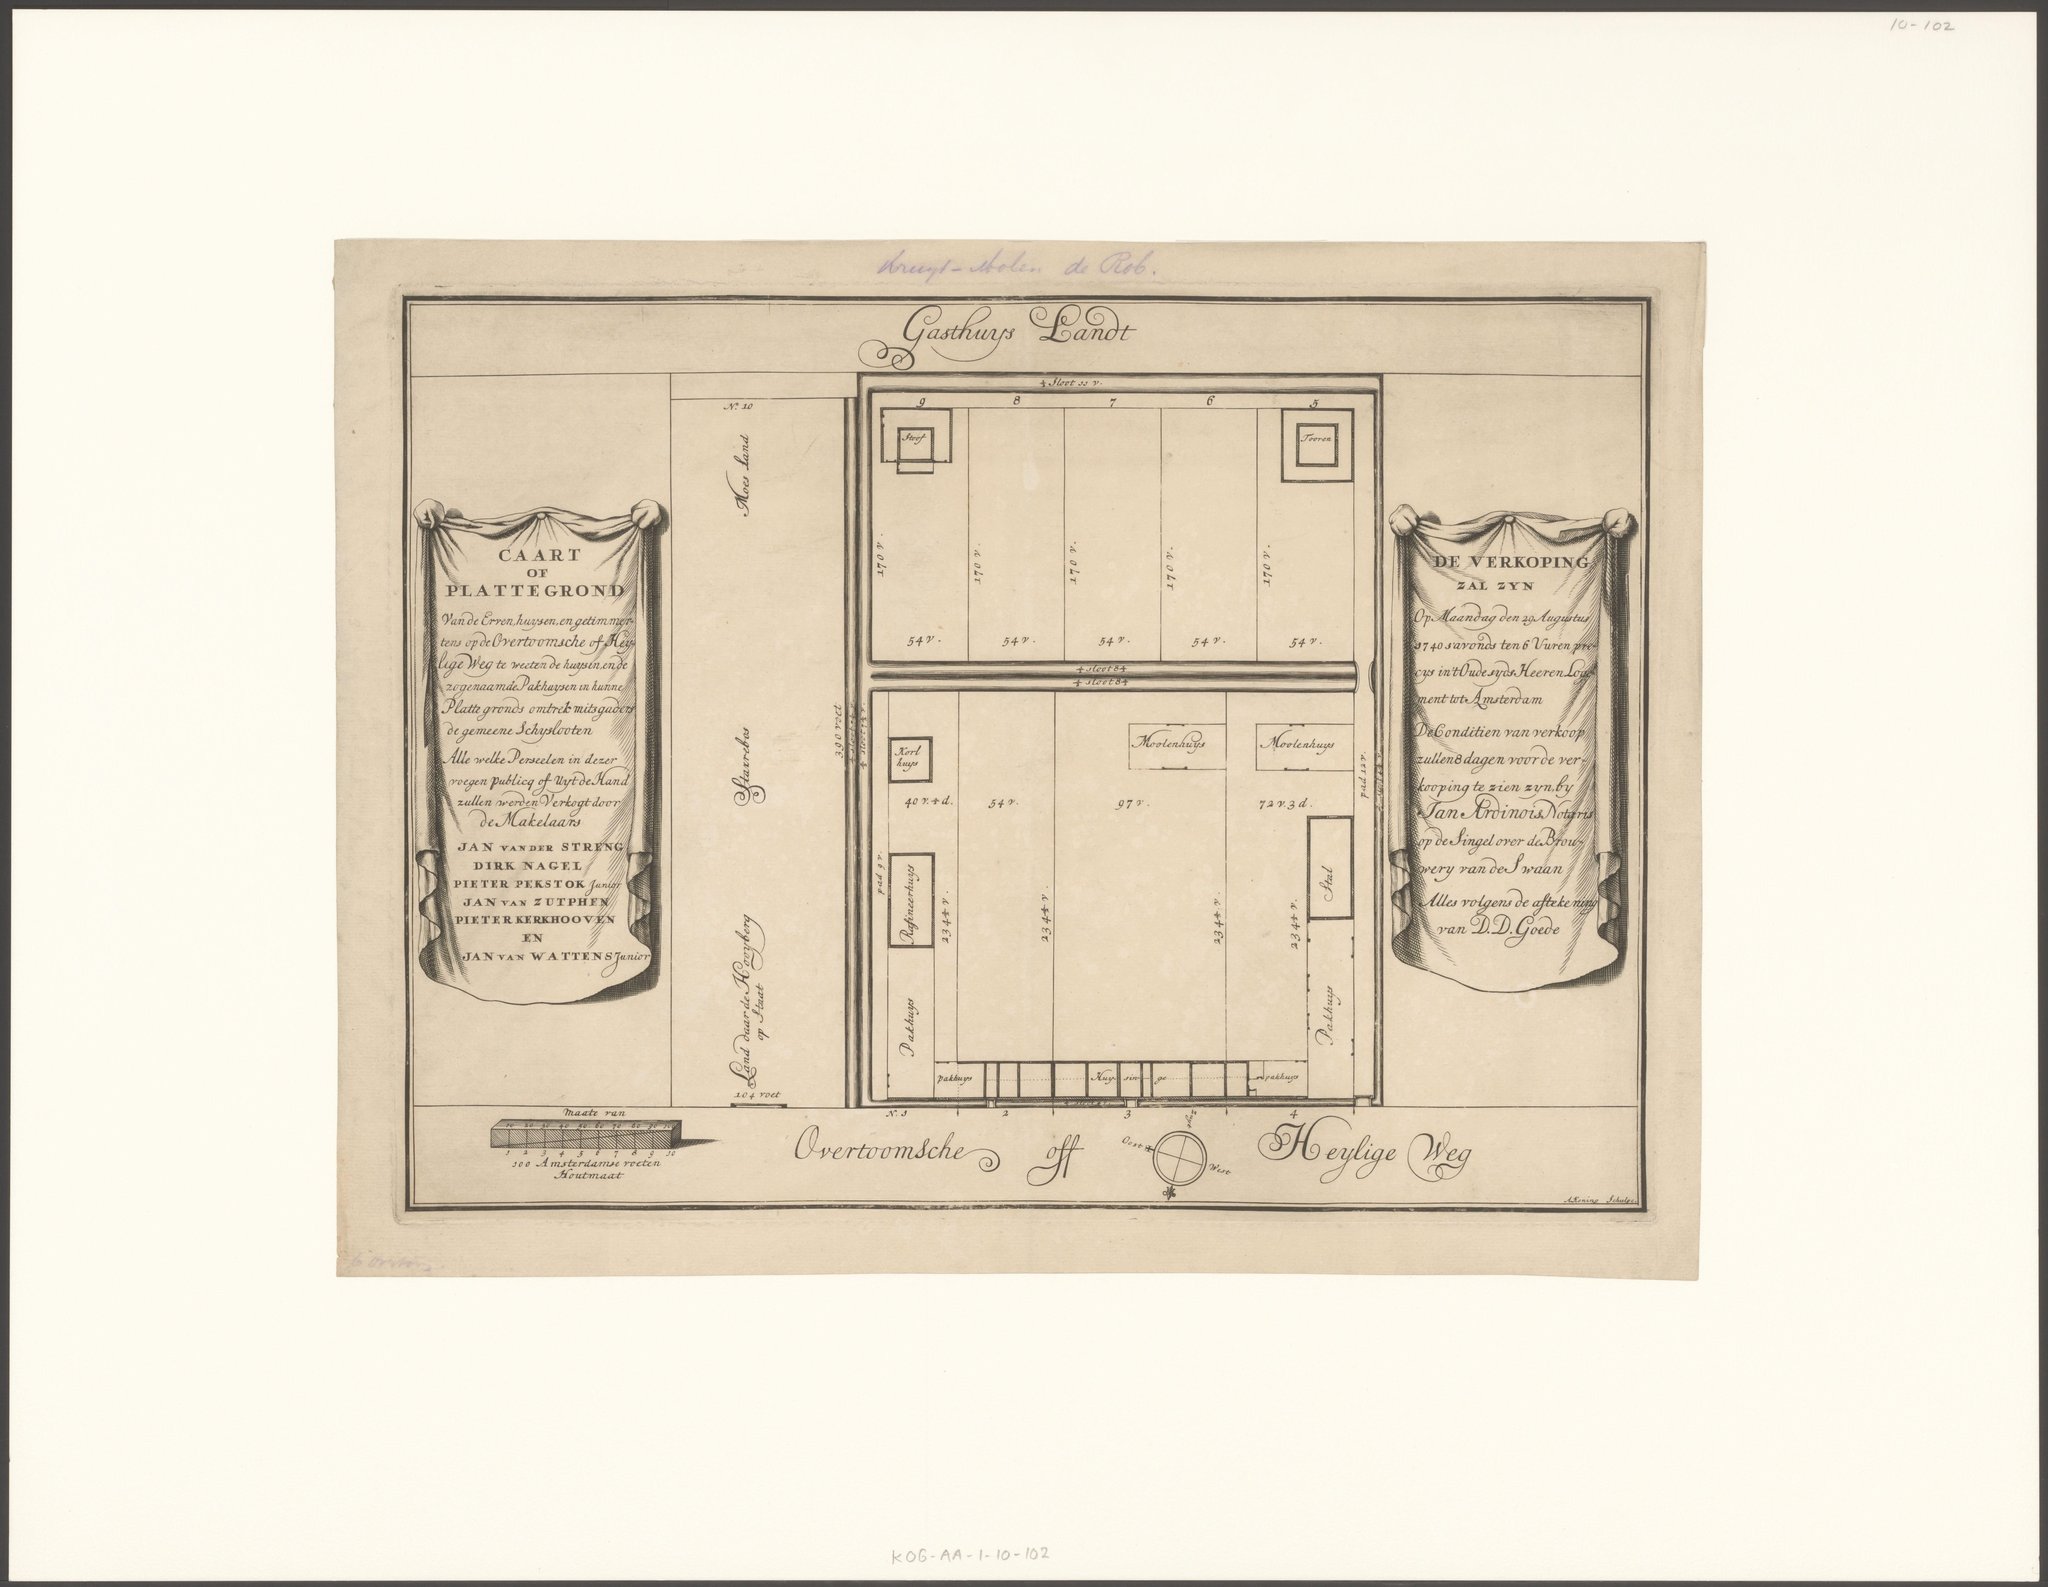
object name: print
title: Plattegrond en verdeling van percelen van het Gasthuis Land op de Heilige Weg te Amsterdam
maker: a. koning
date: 1740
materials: paper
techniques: engraving, etching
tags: plan ~ architecture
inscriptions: inscription: ‘Kruyt-Molen de Rob.’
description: Onderwerpsrubriek binnen de Atlas Amsterdam: Oetgensstraat, Olifantspad, Olofspoort (St.), Onkelboerensteeg, Oosterparkstraat, Oostenburgergracht, Oosterdoksdijk, Osjessluis en Kalverstraat, Ossenspooksteeg, Oudekerksplein, Oudemanhuispoort, Oude Schans.